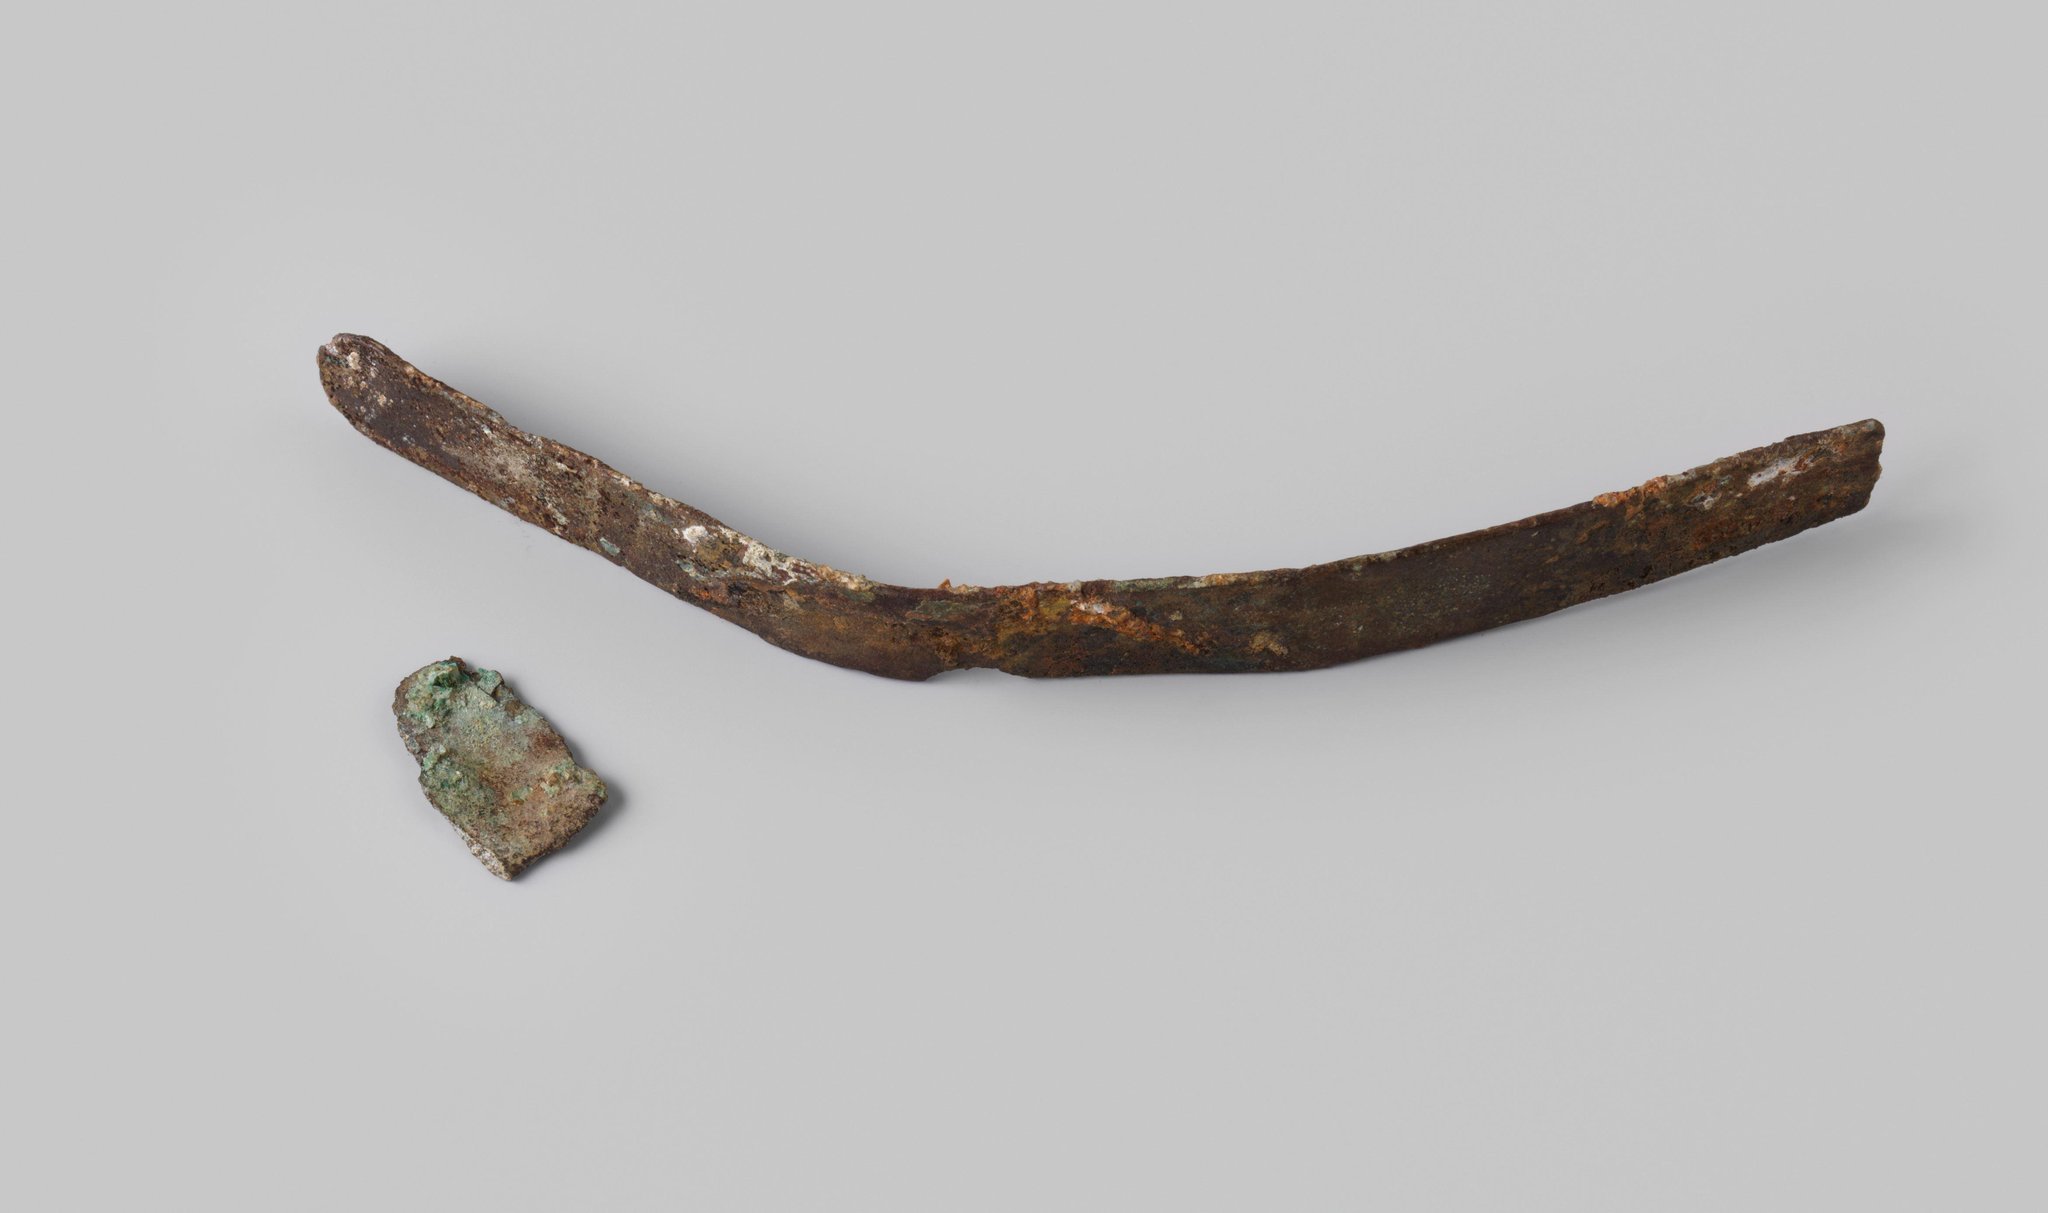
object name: fragment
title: Fragmenten van koperstrips uit het wrak van de Oost-Indiëvaarder Hollandia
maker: Anonymous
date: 1700-1743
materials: copper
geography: netherlands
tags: verenigde oostindische compagnie, hollandia (schip), annet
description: Varied parts or fragments, strips and strip-shaped fragments; fragm.